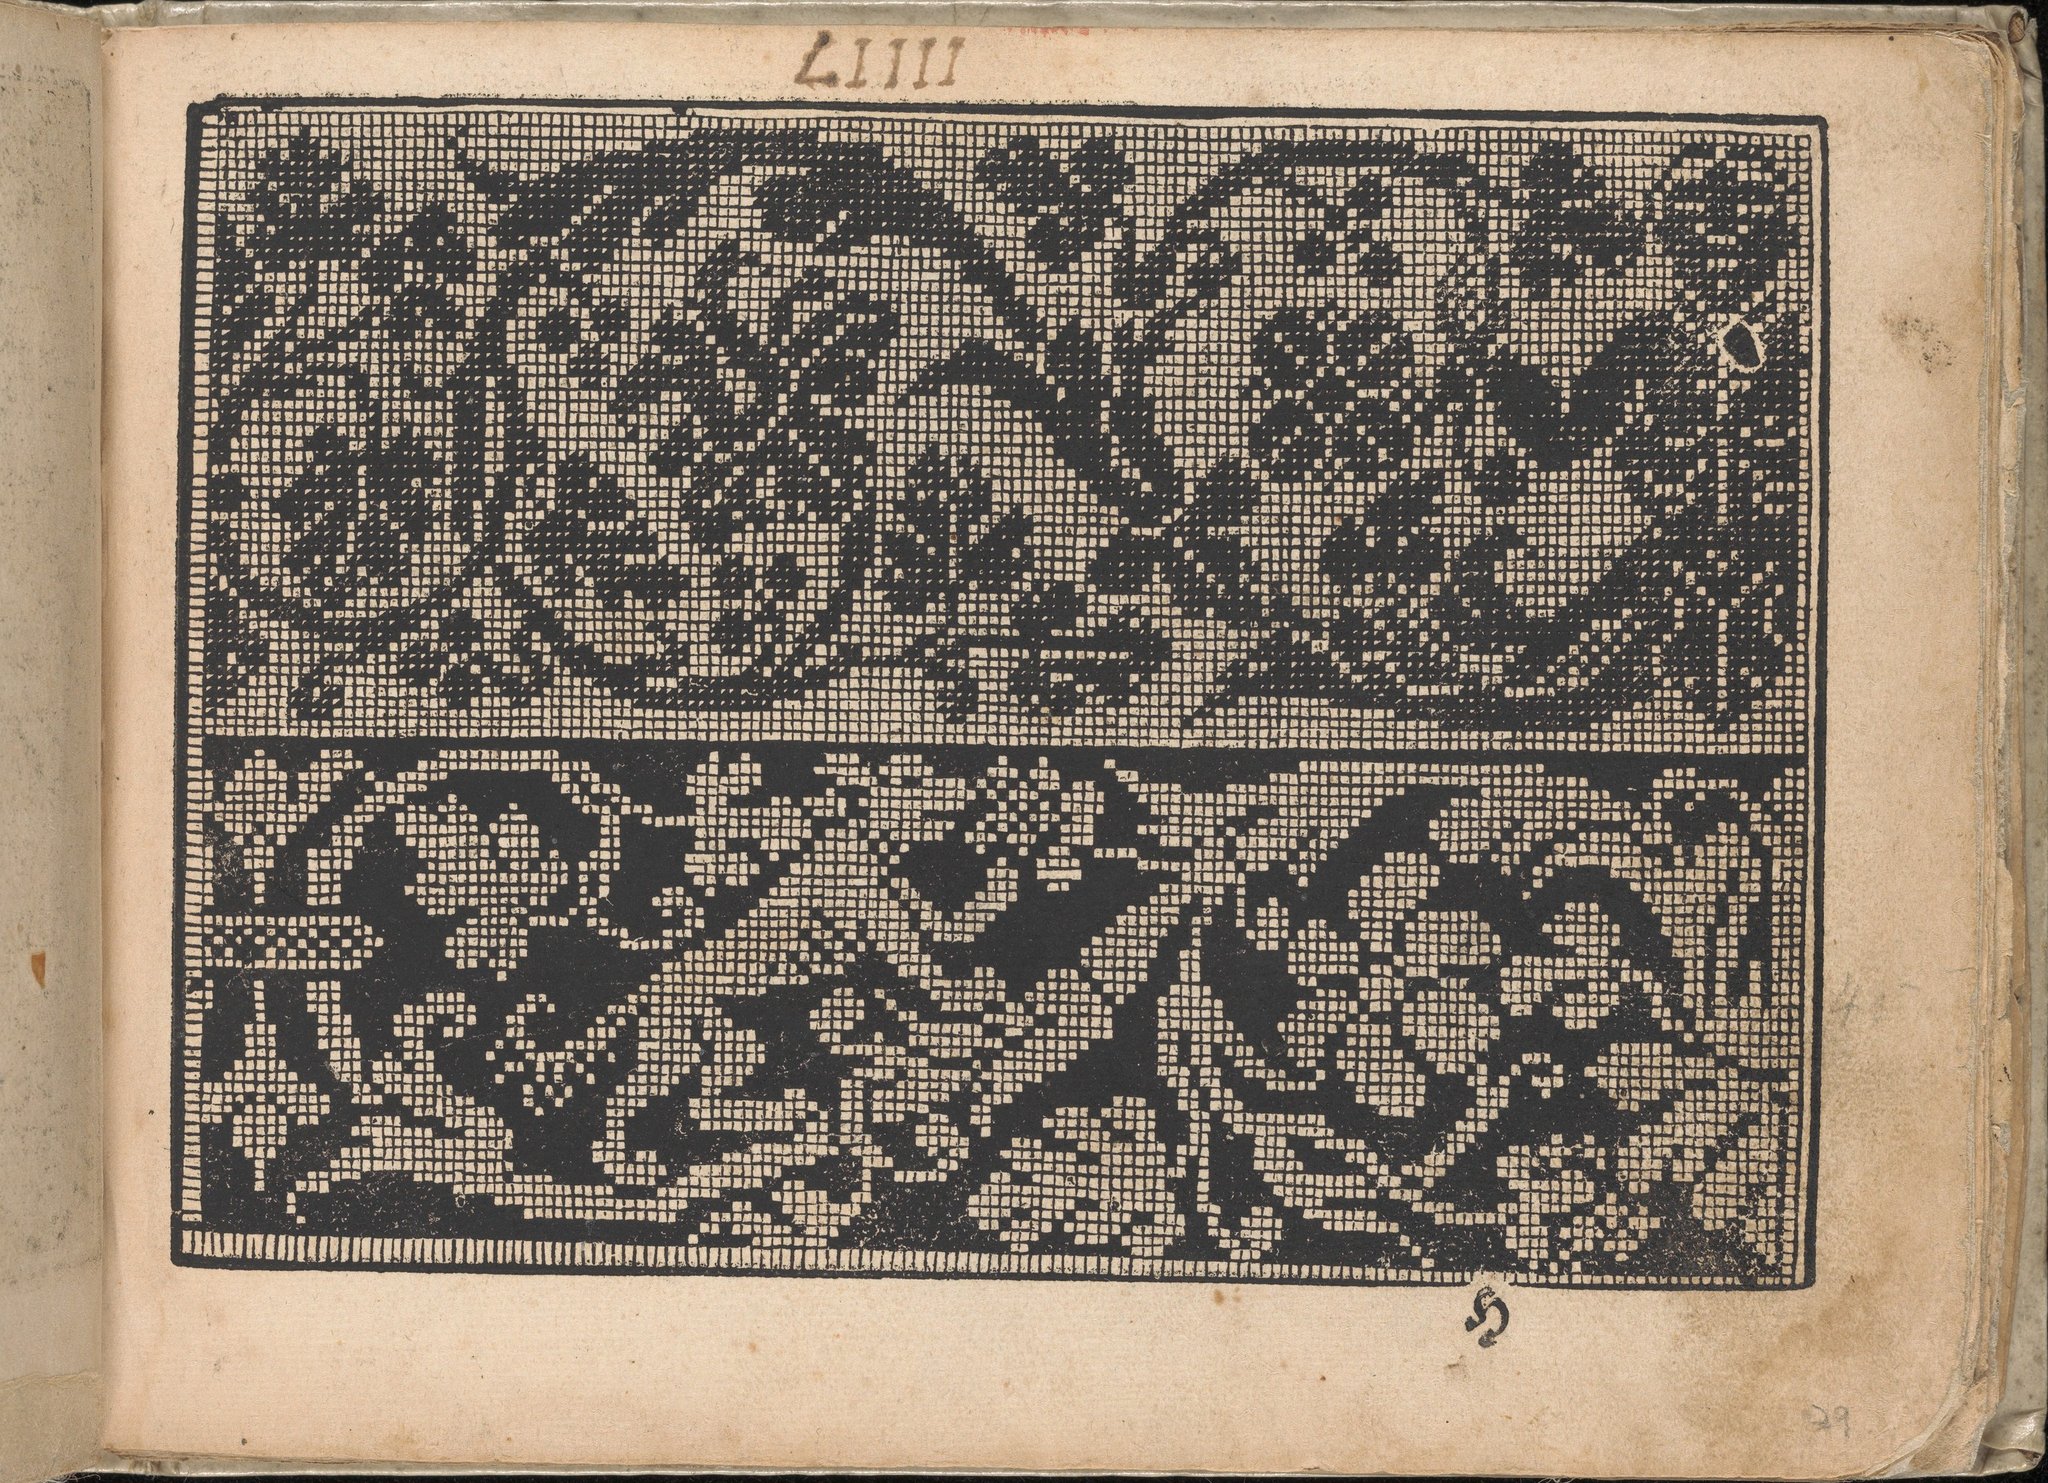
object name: book print ornament architecture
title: Neu künstlich Modelbuch (page 29r)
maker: bernhard jobin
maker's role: publisher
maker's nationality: swiss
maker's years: 1535-1597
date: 1598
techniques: woodcut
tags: animals,flowers